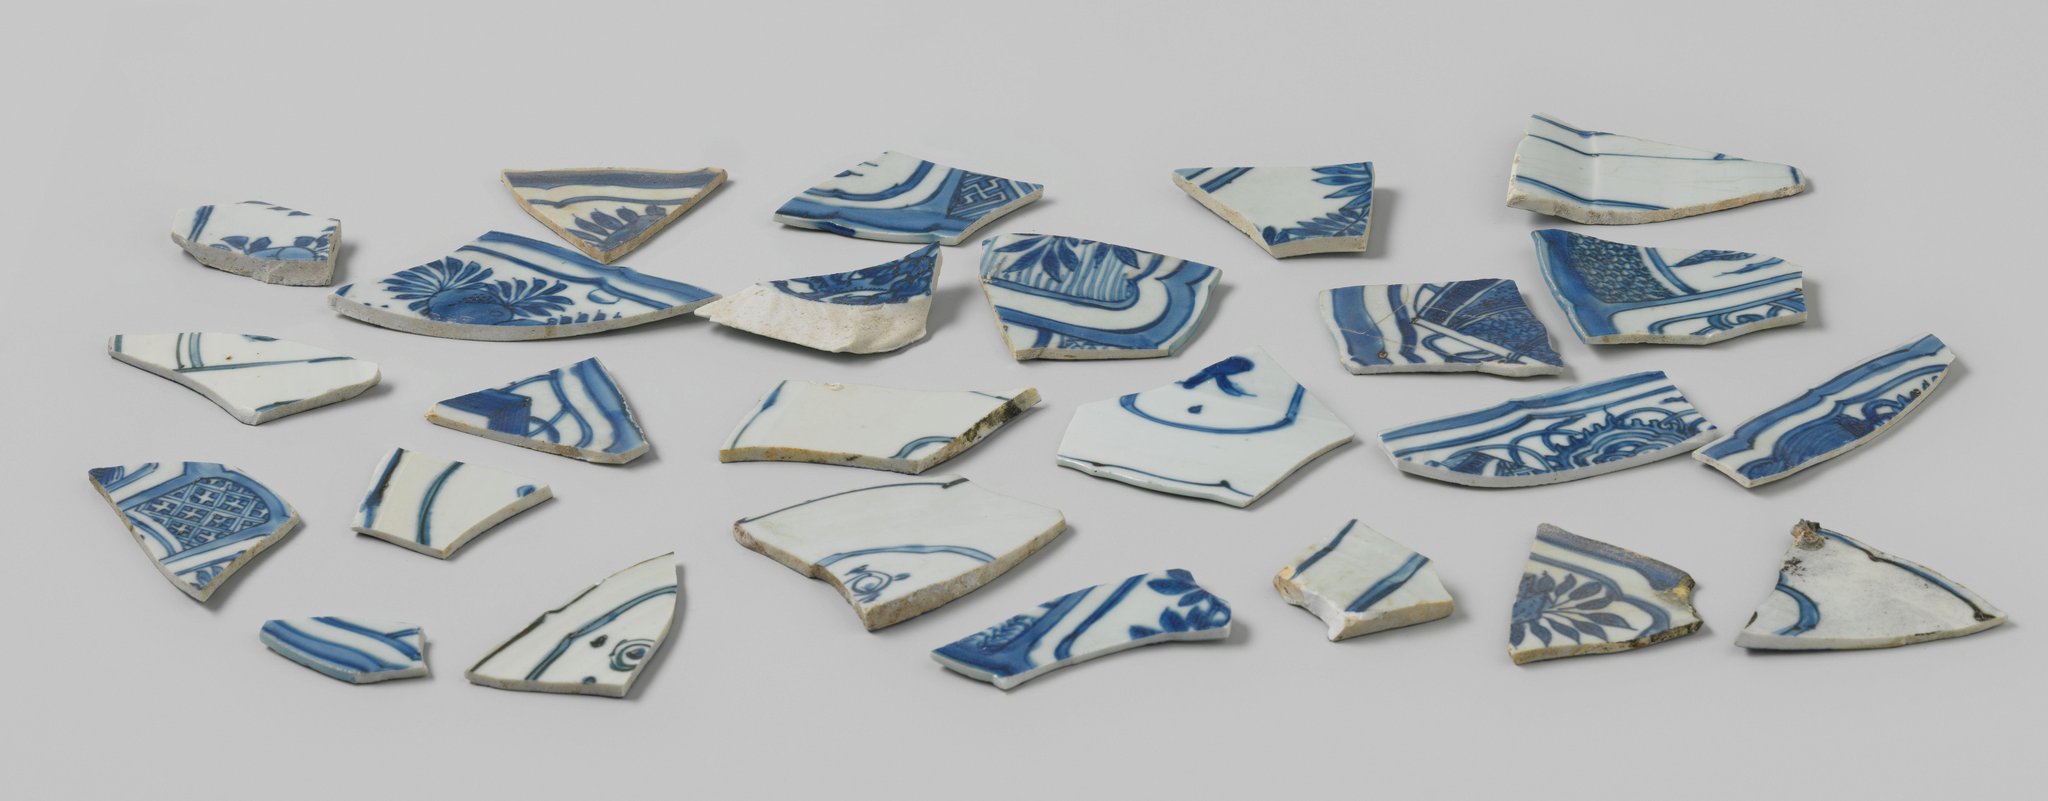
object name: sherd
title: Scherven van borden uit V.O.C.-schip de 'Witte Leeuw'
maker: Anonymous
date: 1613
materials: bone china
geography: jingdezhen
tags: verenigde oostindische compagnie, sint-helena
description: Scherven van borden uit V.O.C.-schip de 'Witte Leeuw'.